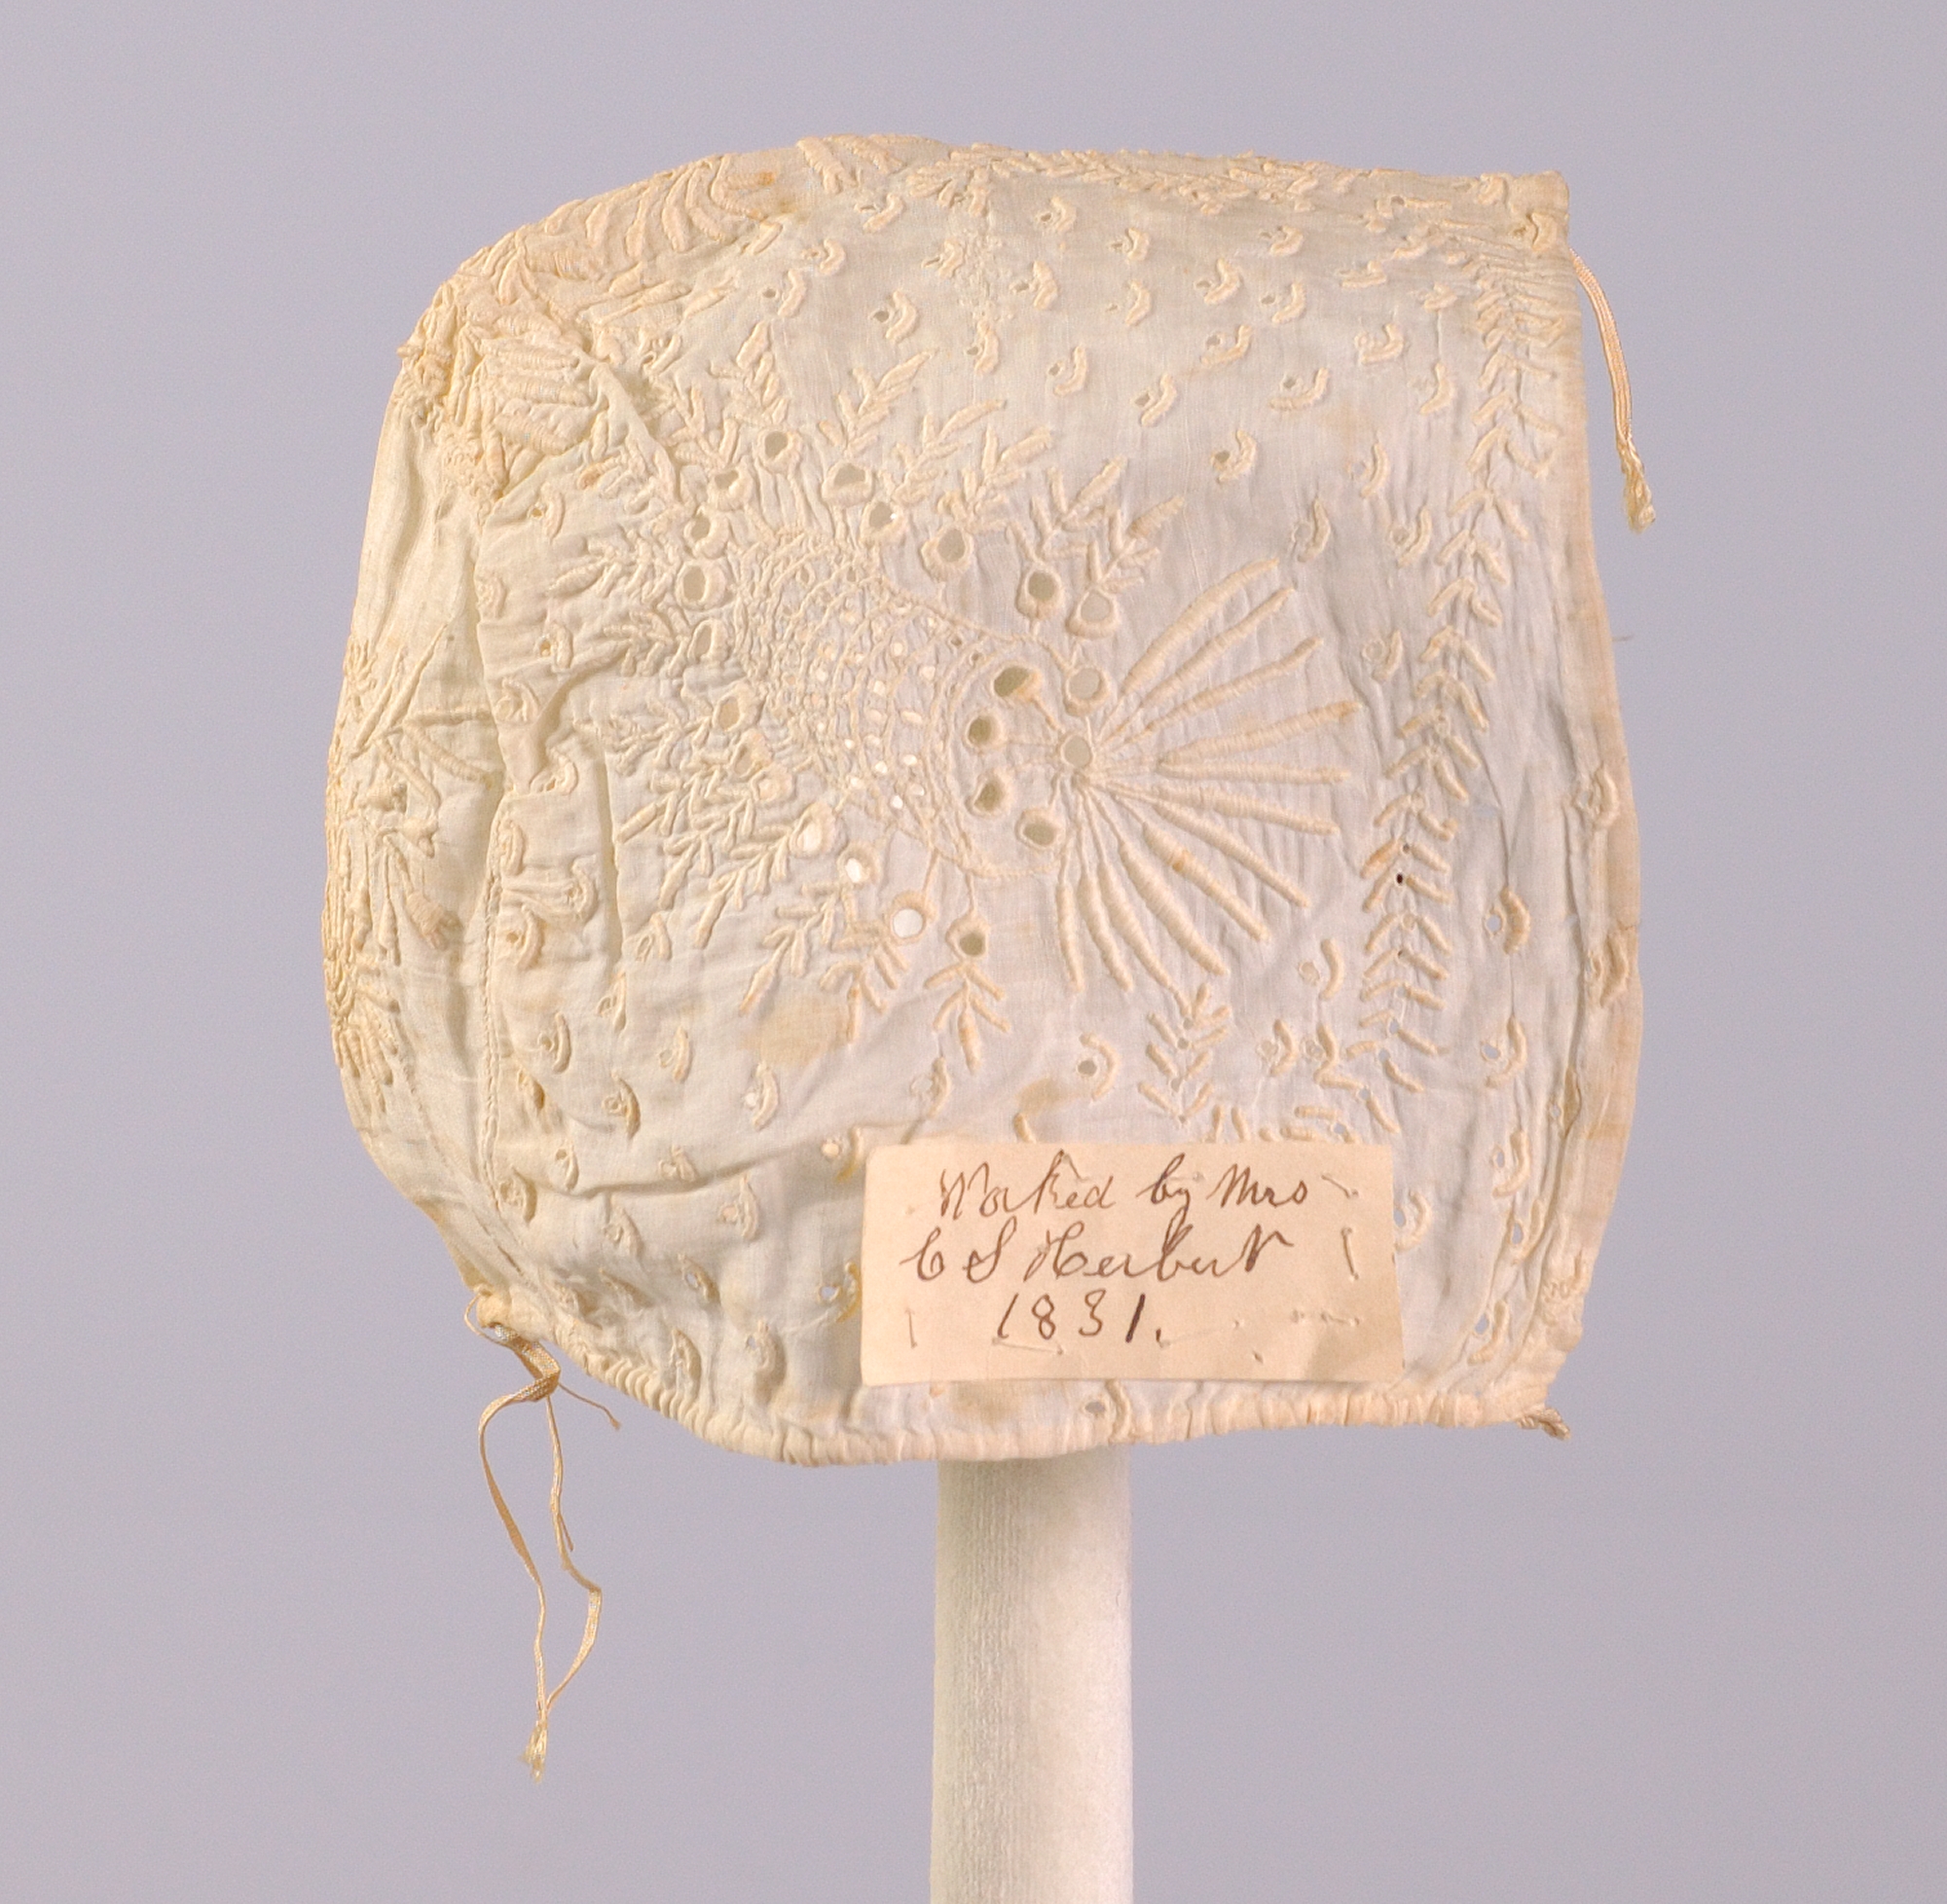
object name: cap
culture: american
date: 1831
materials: cotton